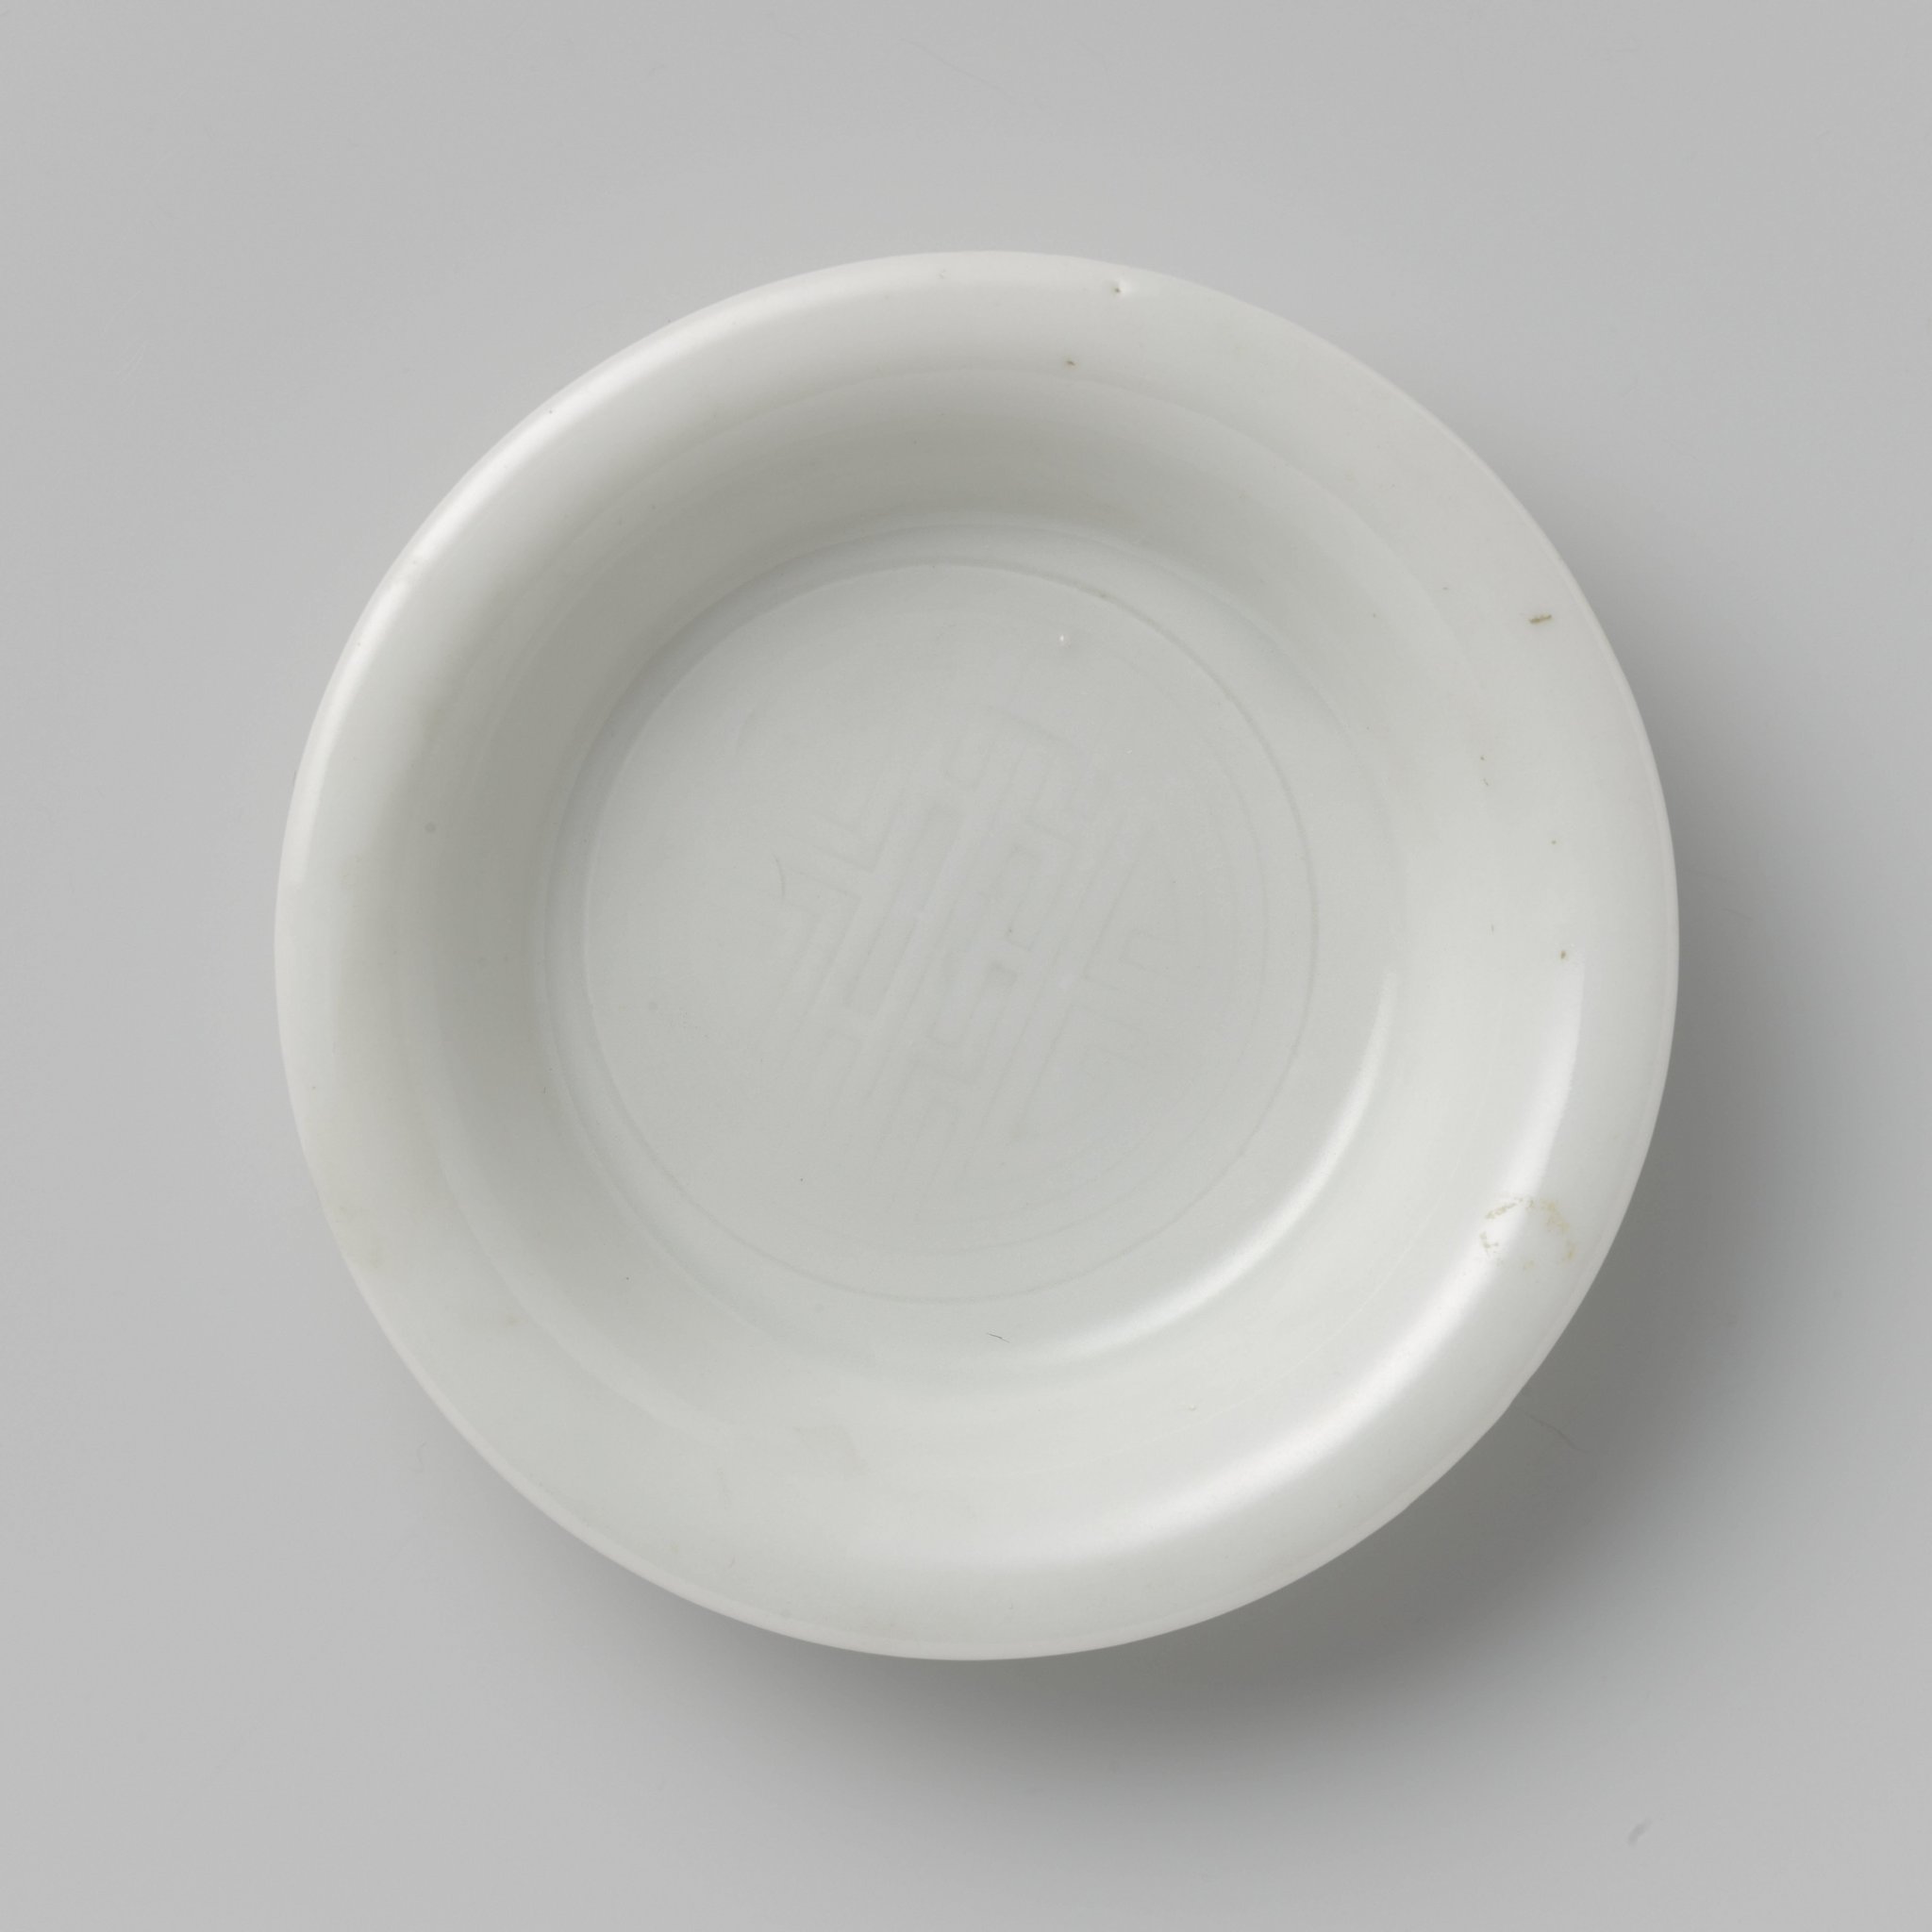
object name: platter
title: Small dish with incised 'shou' symbol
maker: Anonymous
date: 1368-1500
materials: glaze, porcelain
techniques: firing, turning, vitrification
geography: china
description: Schotel van porselein, bedekt met een doorschijnend wit glazuur. Op het plat het ingegrifte 'shou' symbool, lang leven, in een medaillon. Ming porselein.